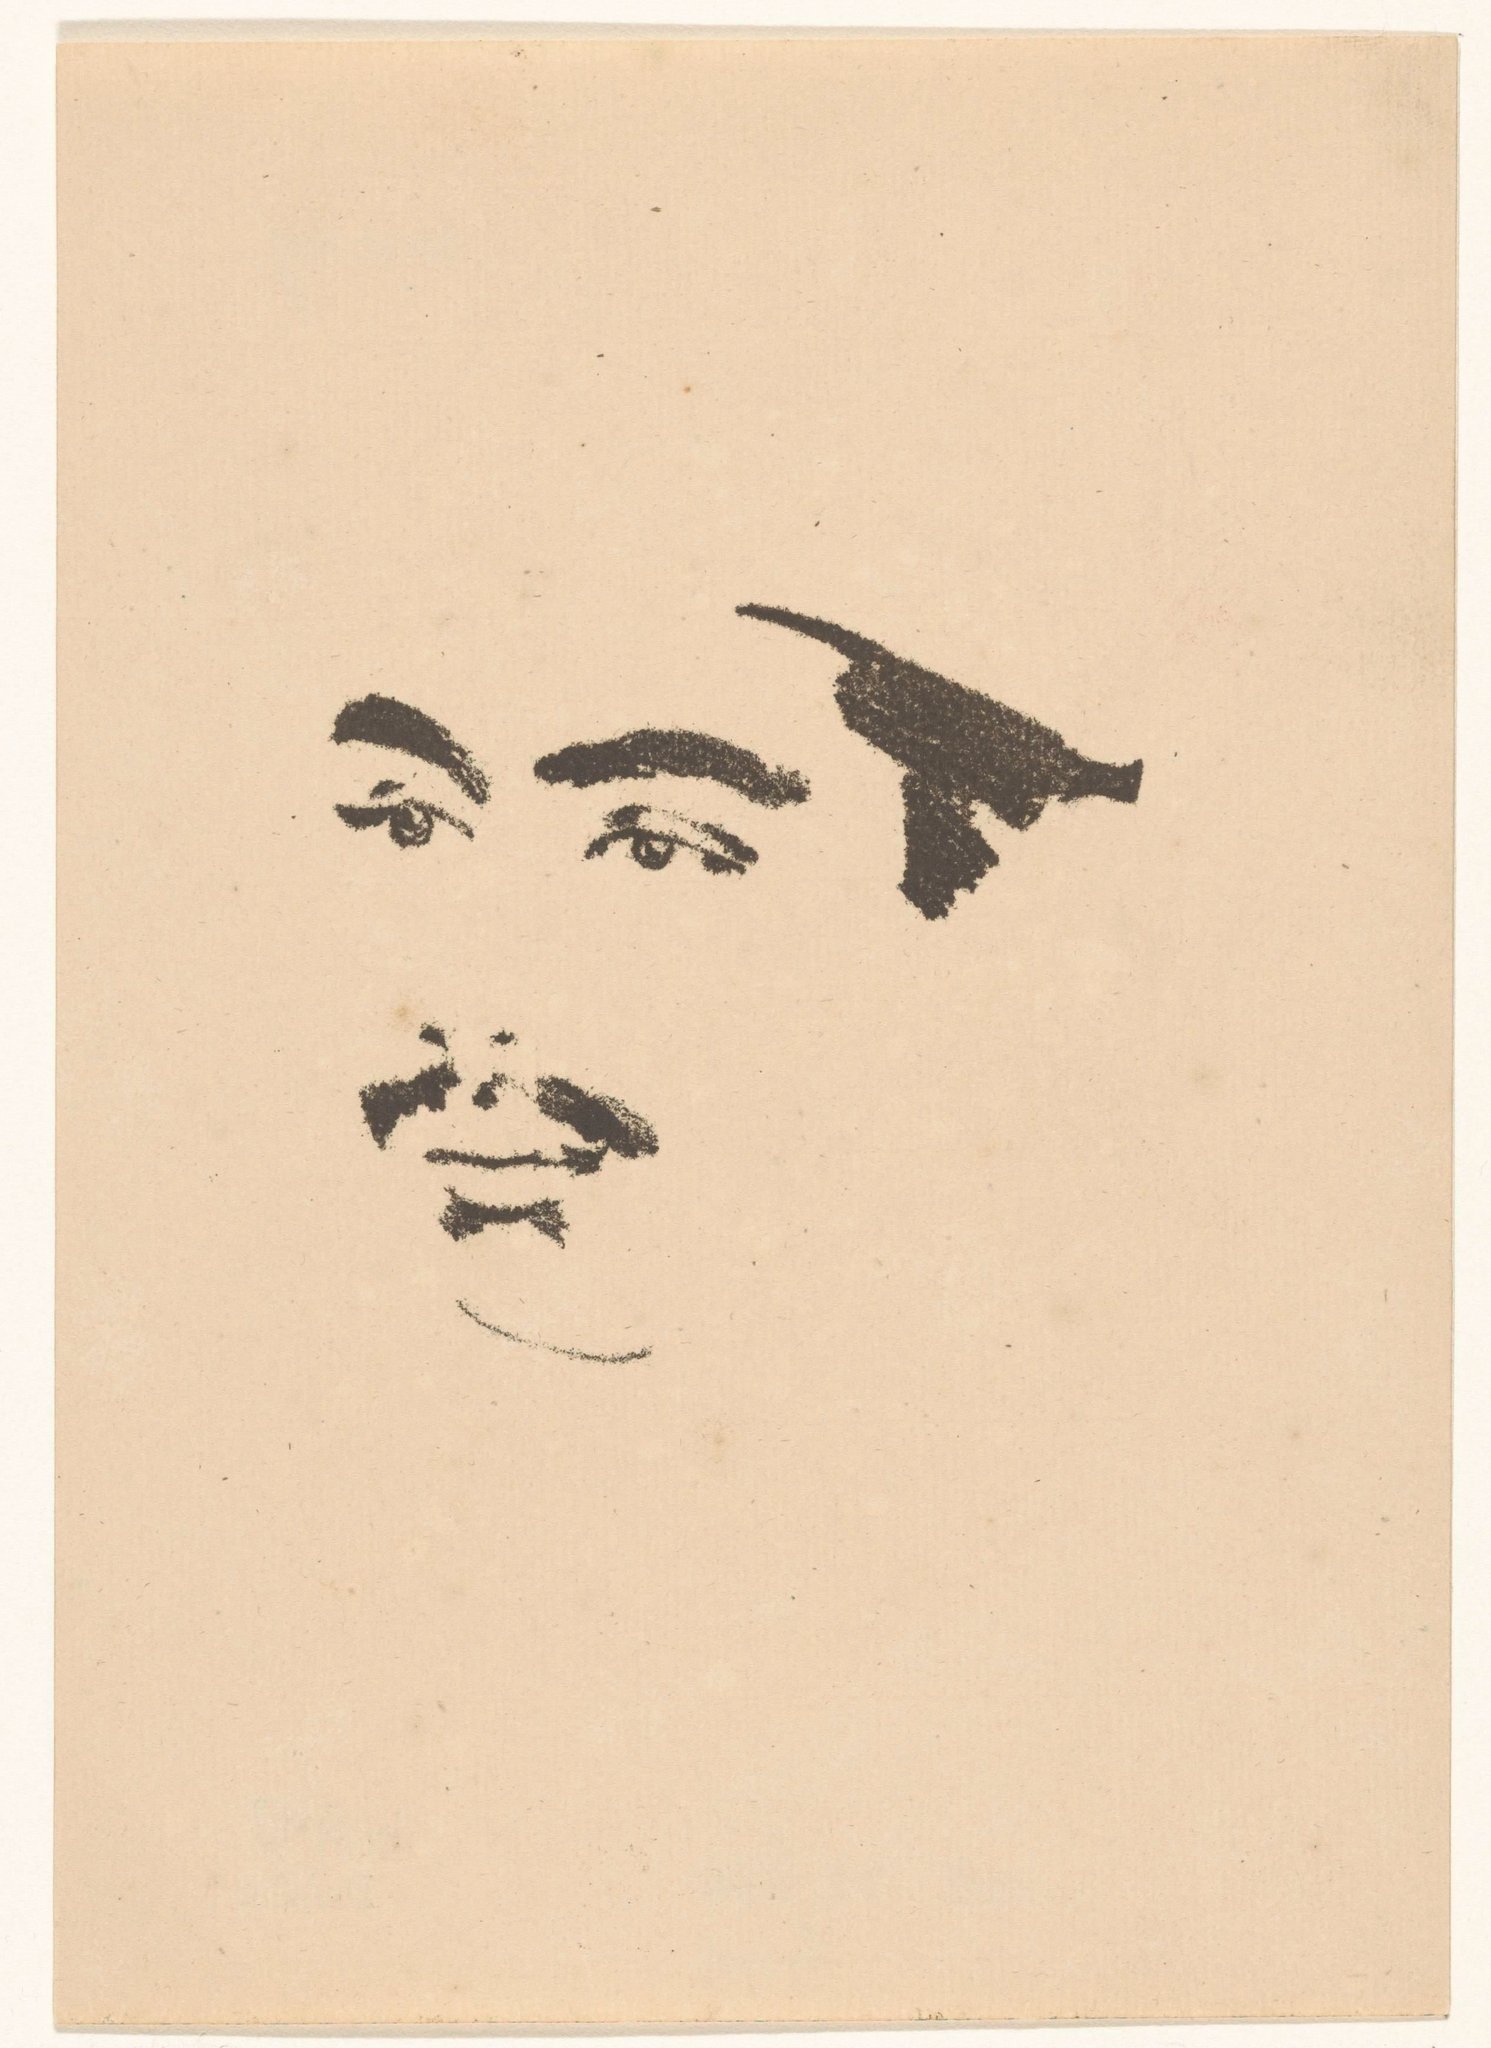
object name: print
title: Portret van een Indonesische man uit West-Java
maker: willem witsen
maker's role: draughtsman, painter, print maker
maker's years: 1860-1923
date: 1921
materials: paper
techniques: soft ground etching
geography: amsterdam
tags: anonymous historical person portrayed alone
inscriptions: watermark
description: Alleen de haren, wenkbrauwen, ogen, snor, mond en kin afgebeeld. Mogelijk een portret van een Soendanese bediende werkzaam in Hotel Bellevue in Buitenzorg.